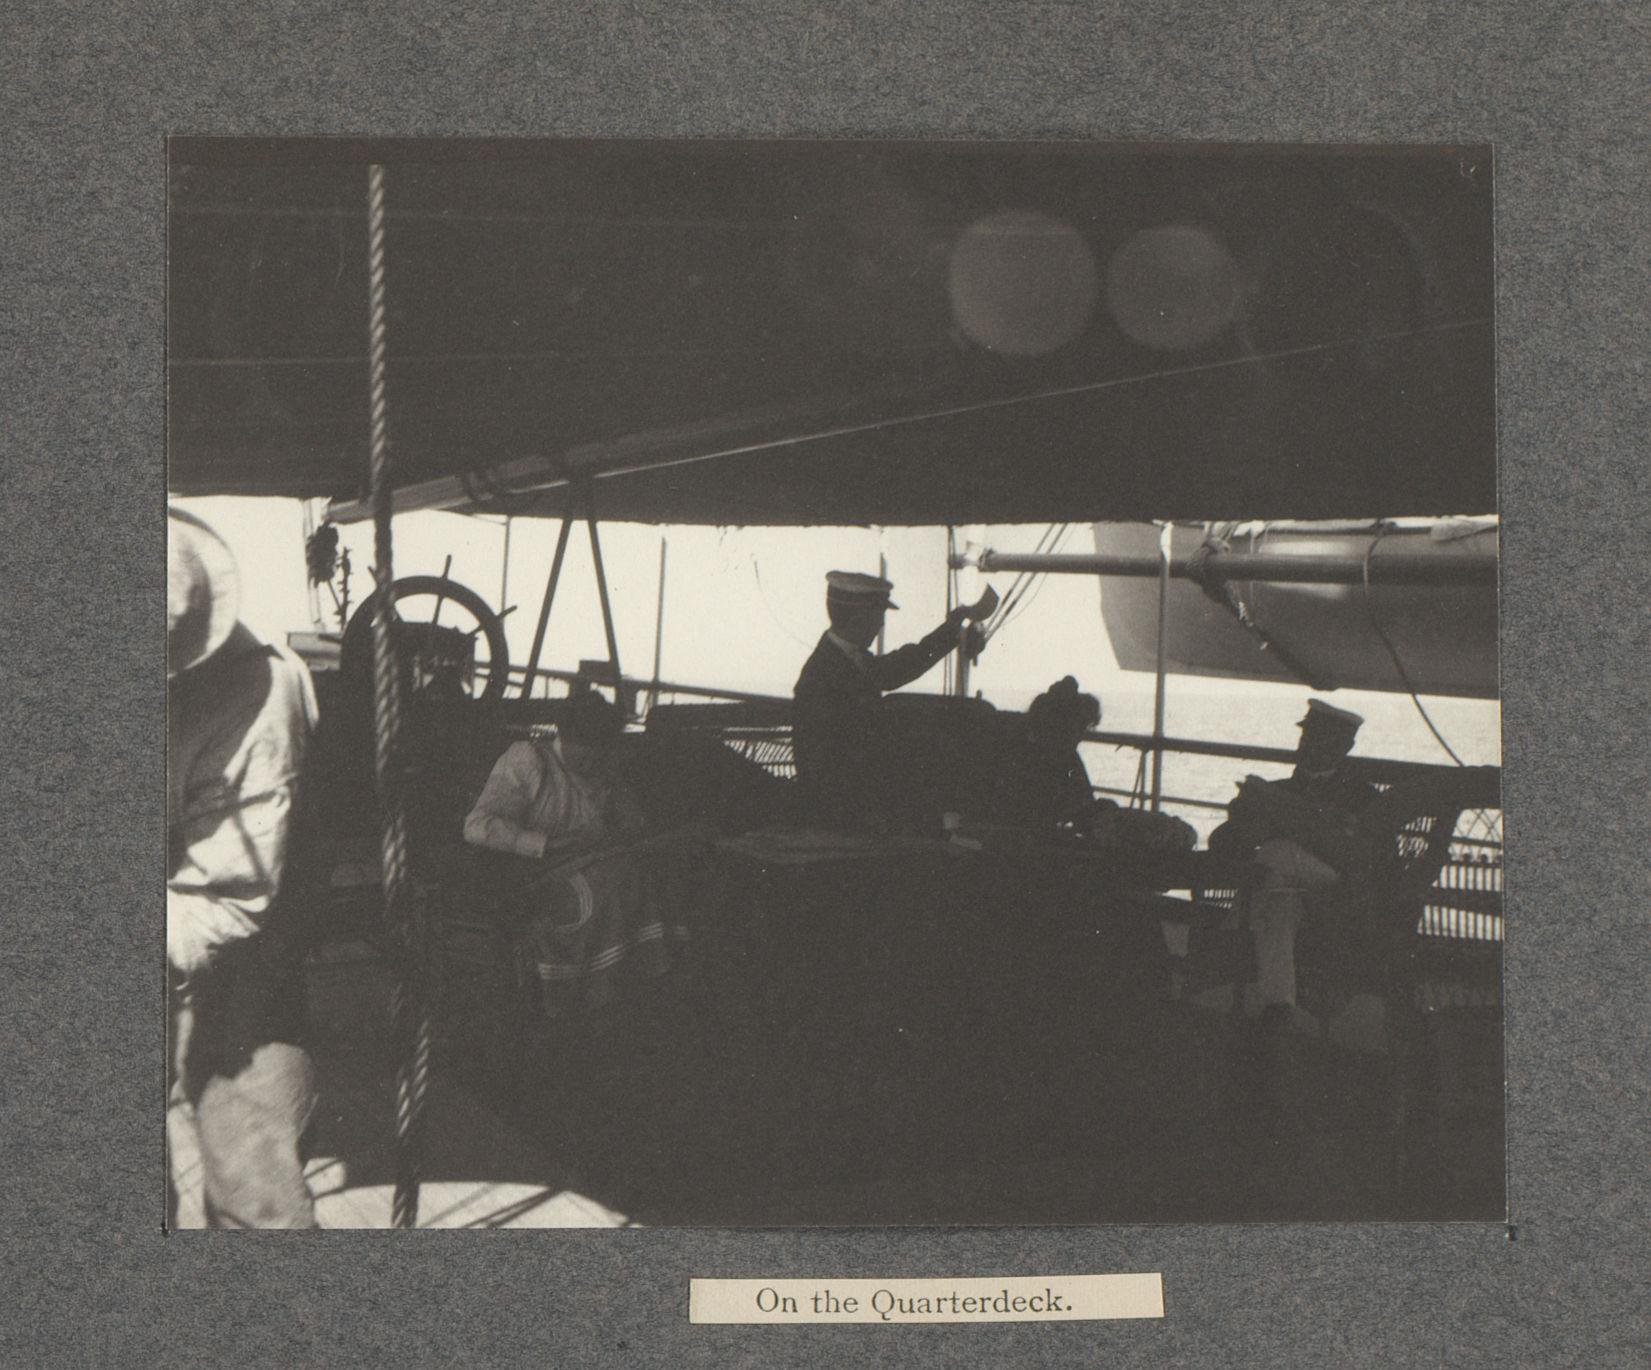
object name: album leaf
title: On the Quarterdeck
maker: Anonymous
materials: paper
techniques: platinum process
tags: crew ~ ship, parts of ship's exterior, historical persons